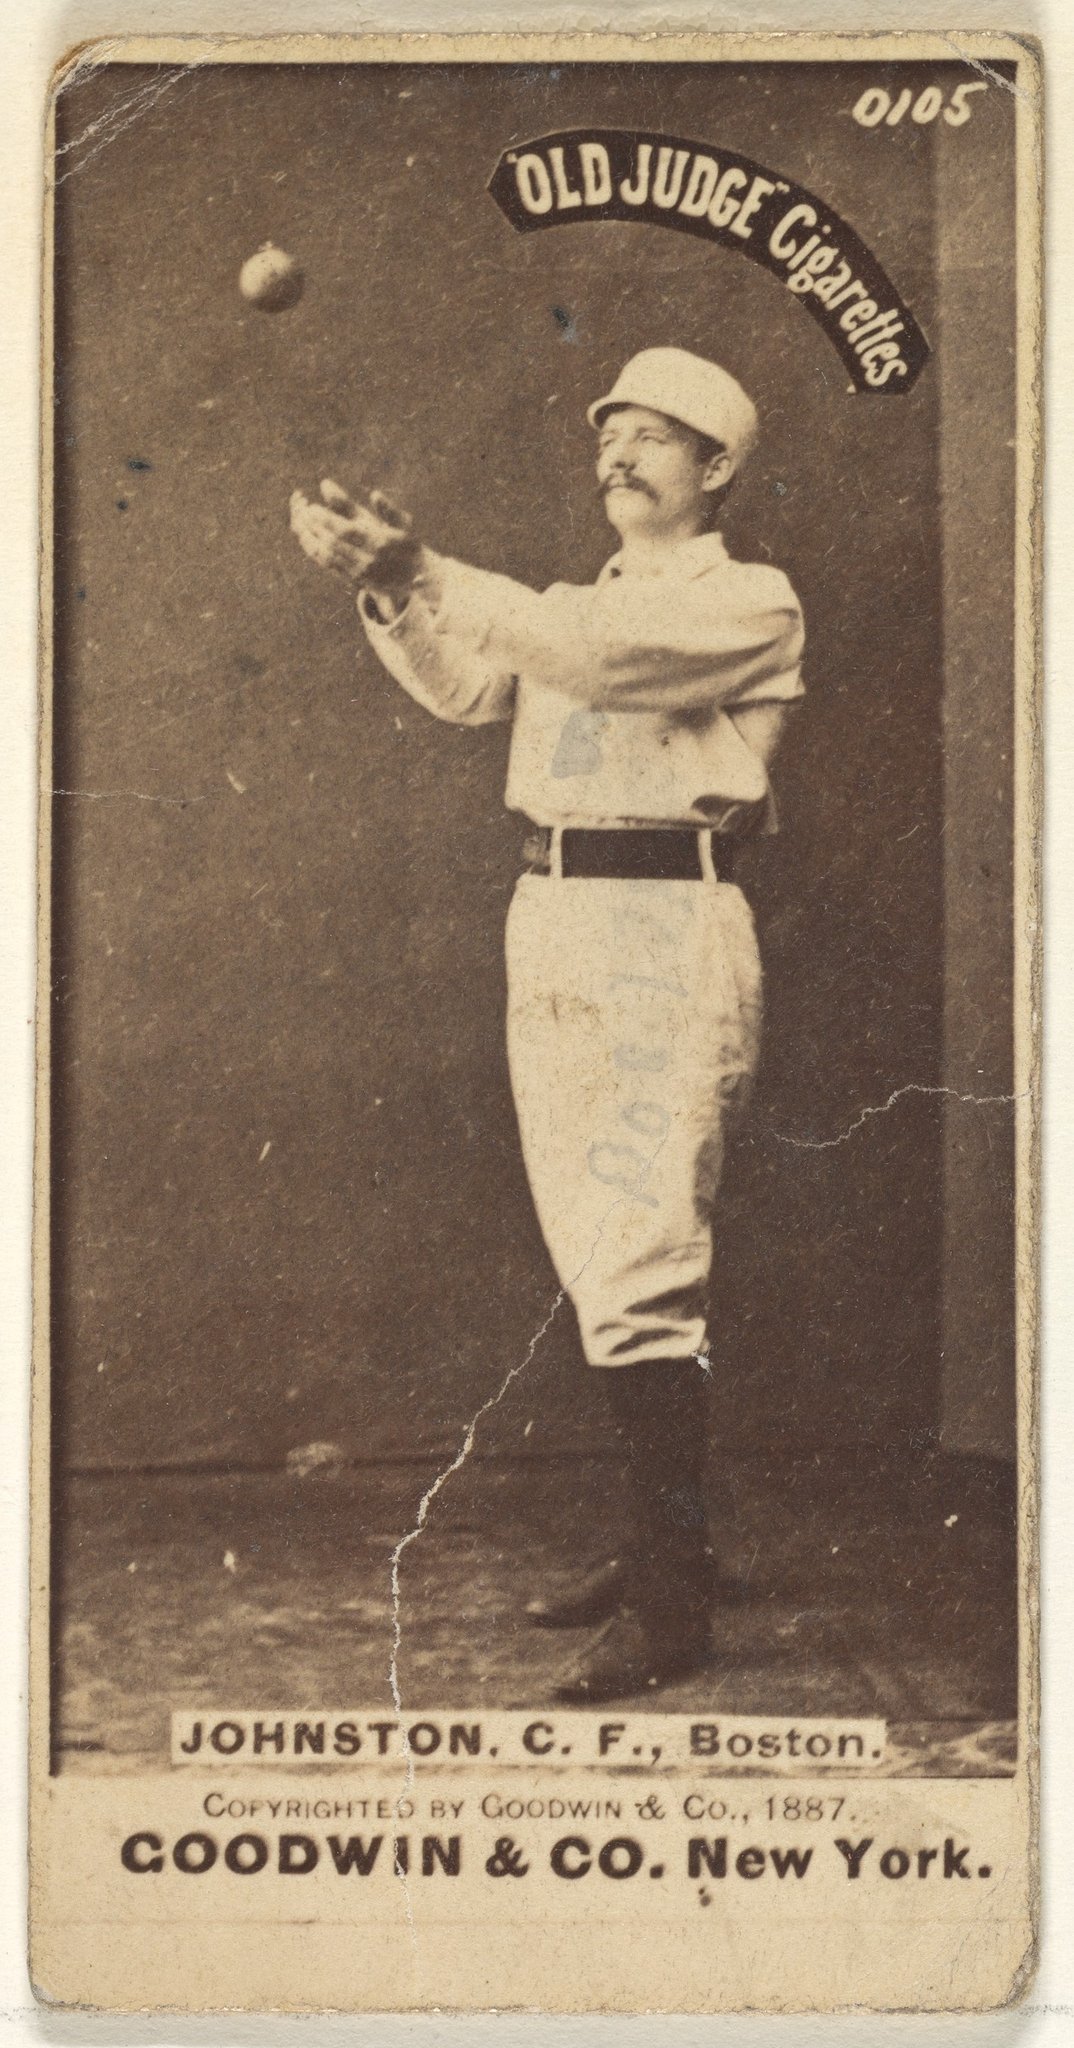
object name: baseball card, photograph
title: Johnston, Center Field, Boston, from the Old Judge series (N172) for Old Judge Cigarettes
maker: goodwin & company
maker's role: publisher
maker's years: 1850-1950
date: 1887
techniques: albumen silver print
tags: men,portraits,baseball,athletes